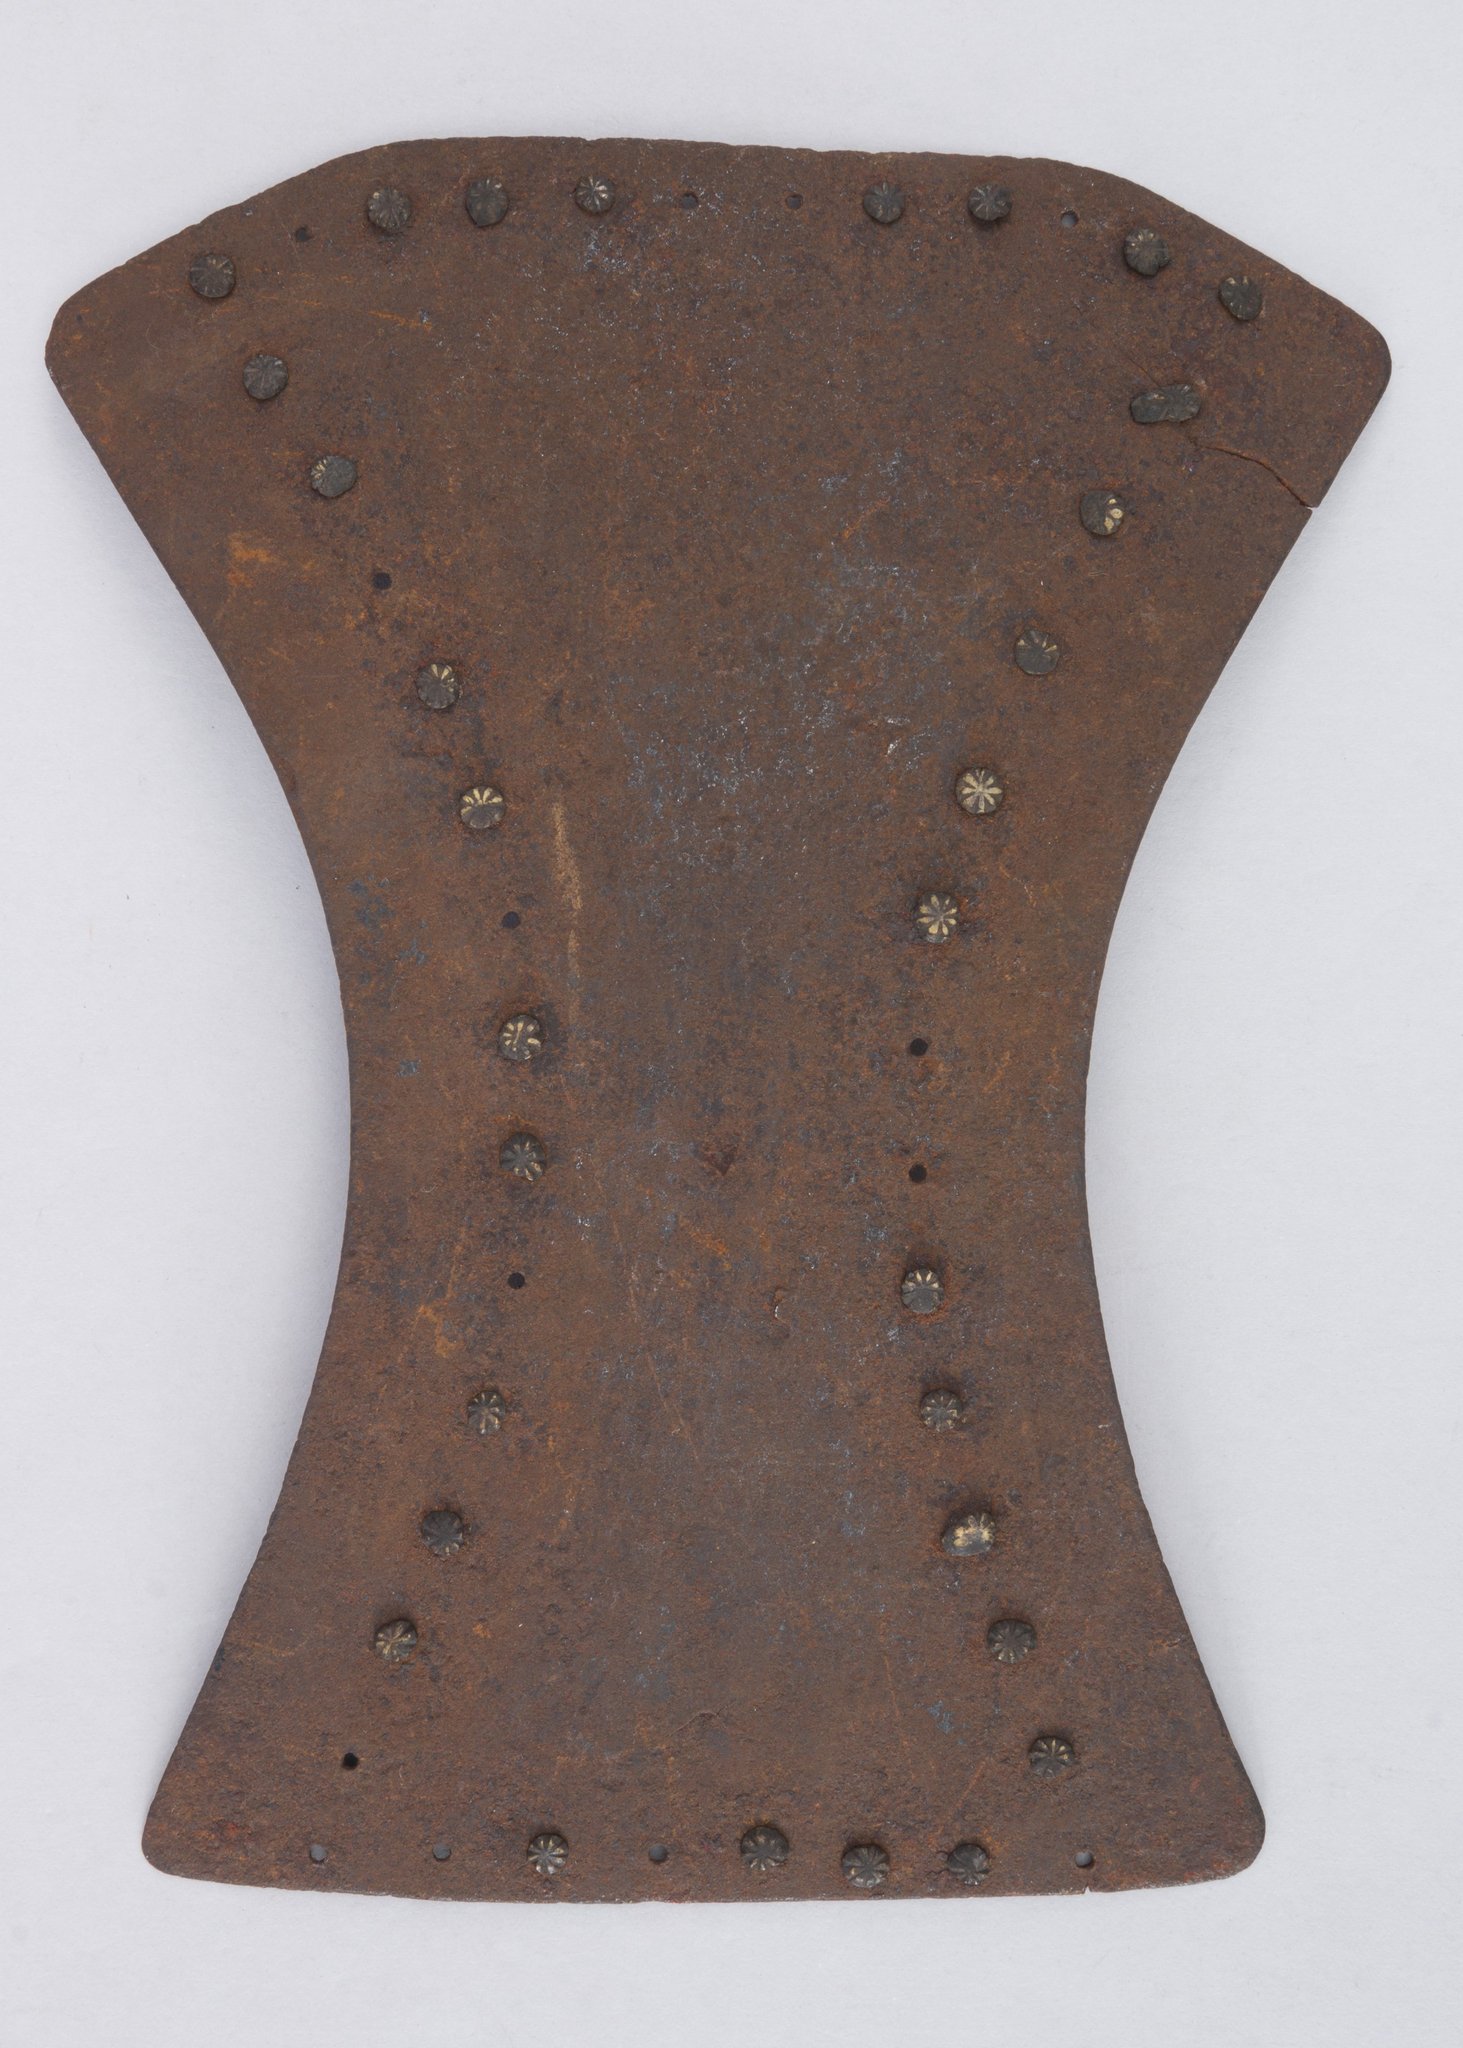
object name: brigandine plate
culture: italian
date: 1400-1450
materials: copper alloy, metal alloy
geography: italy